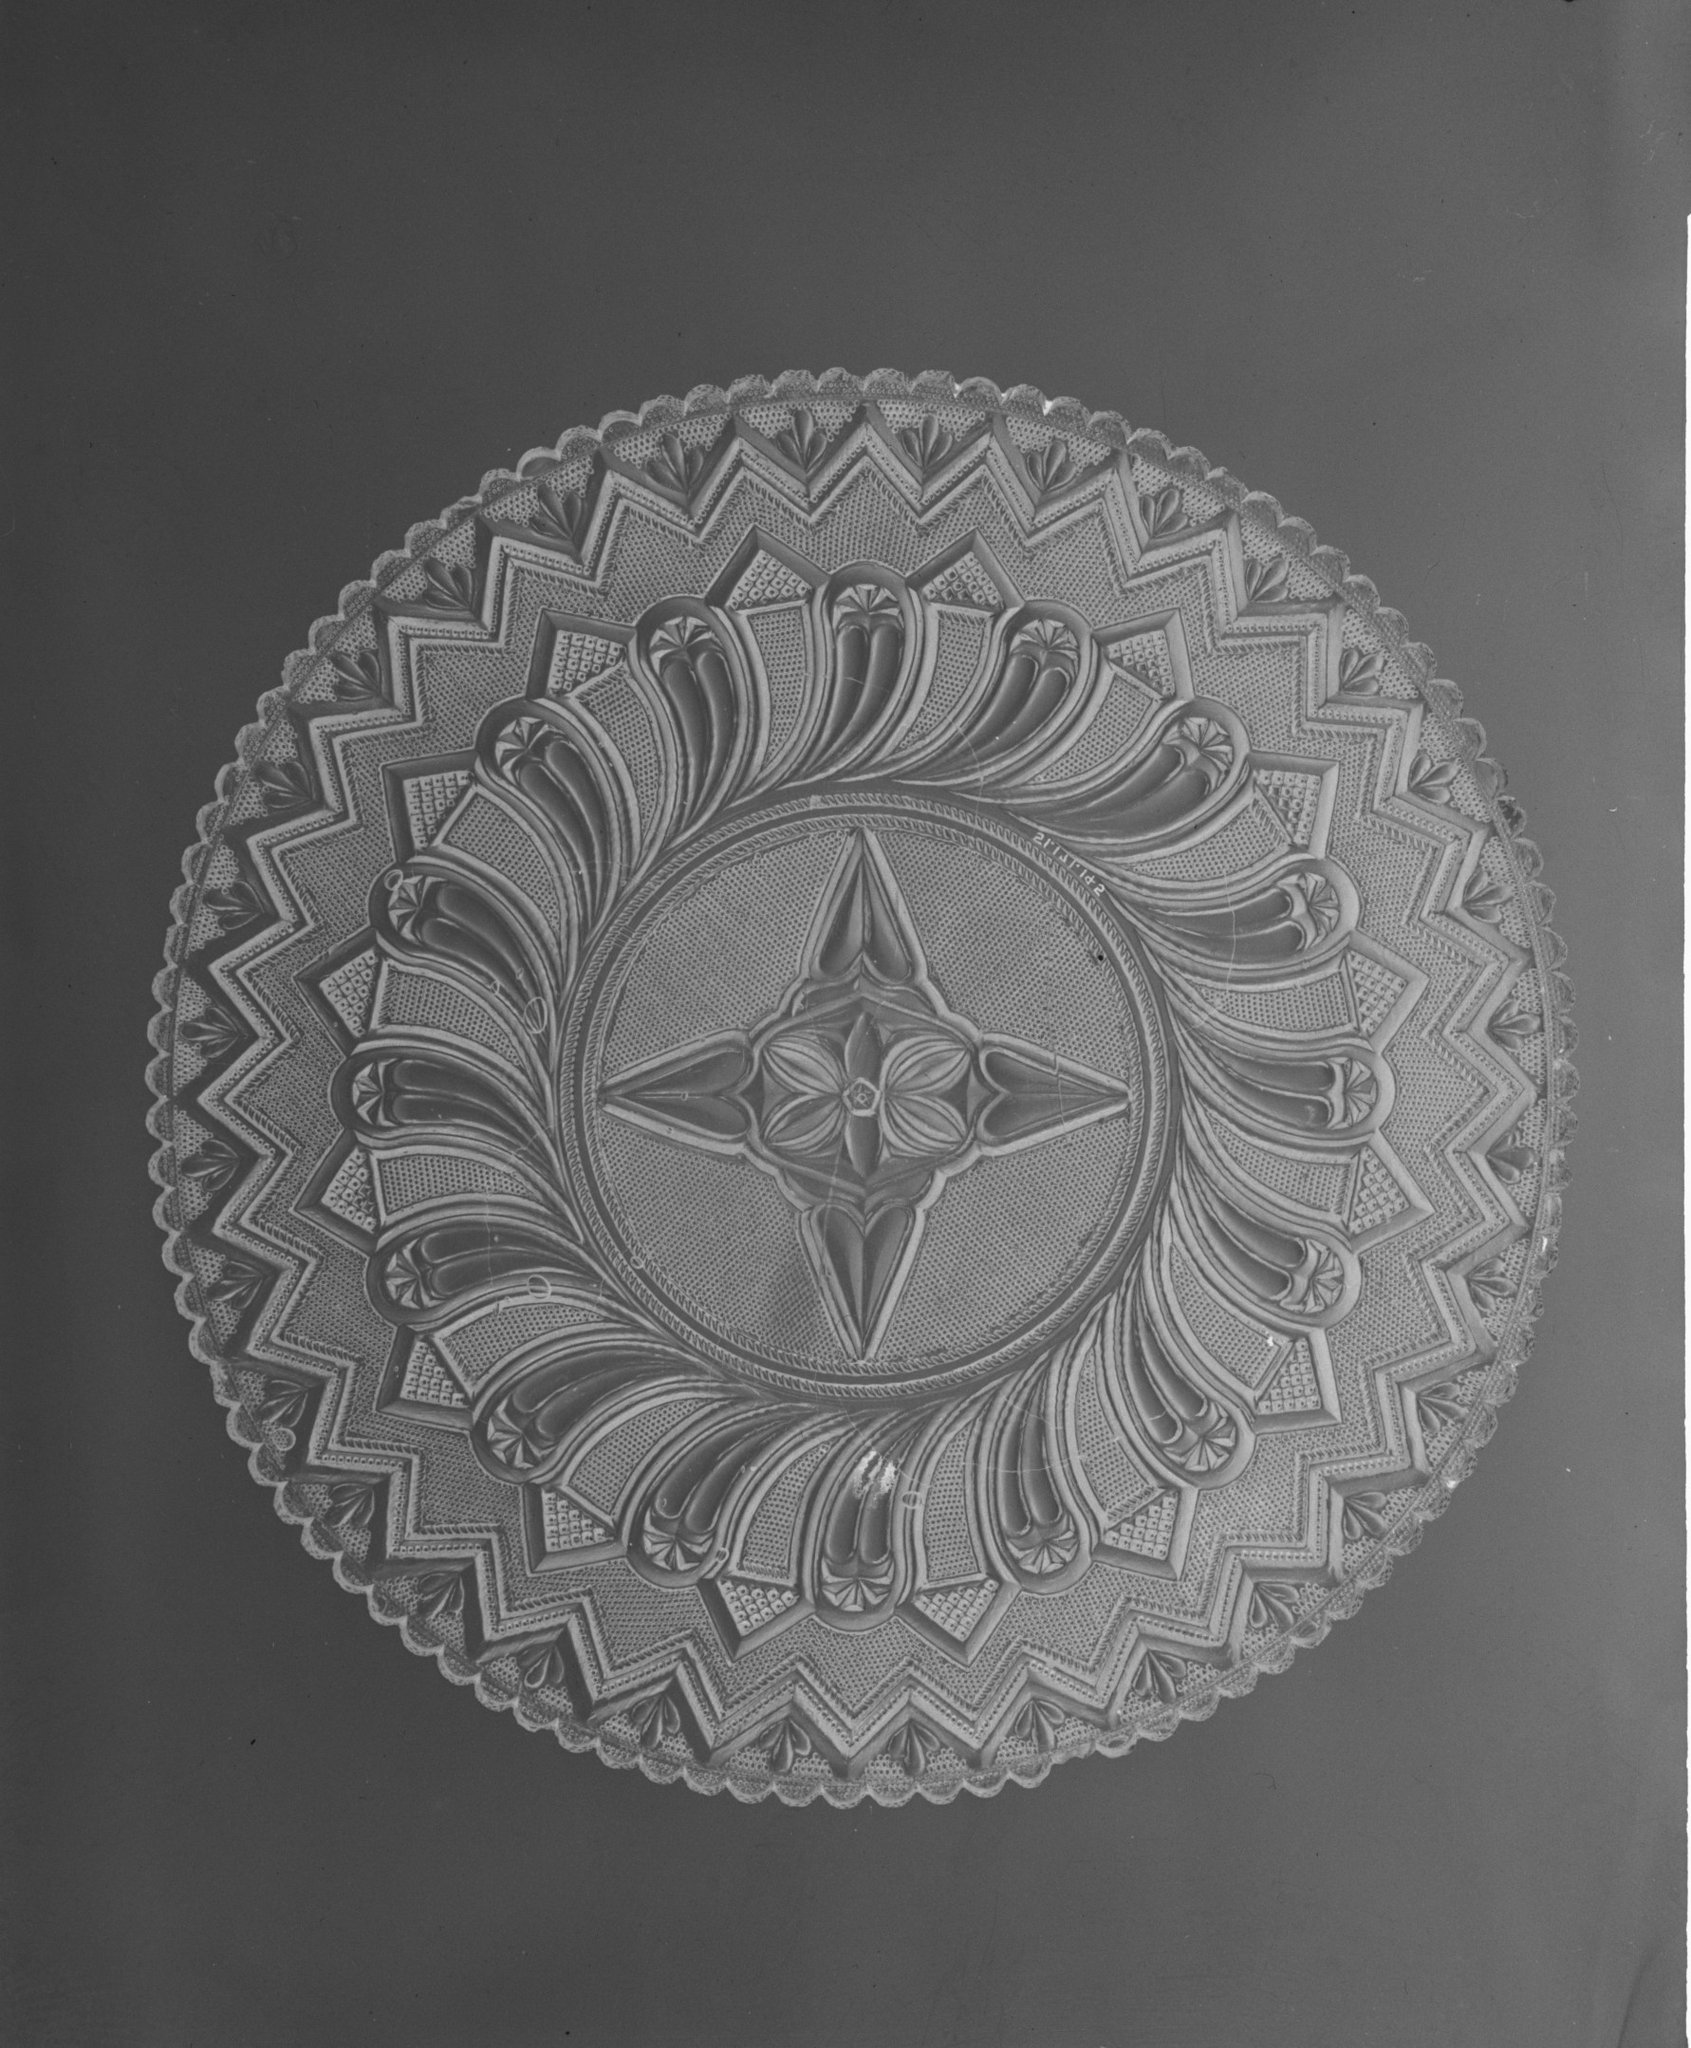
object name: plate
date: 1830-1840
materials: glass